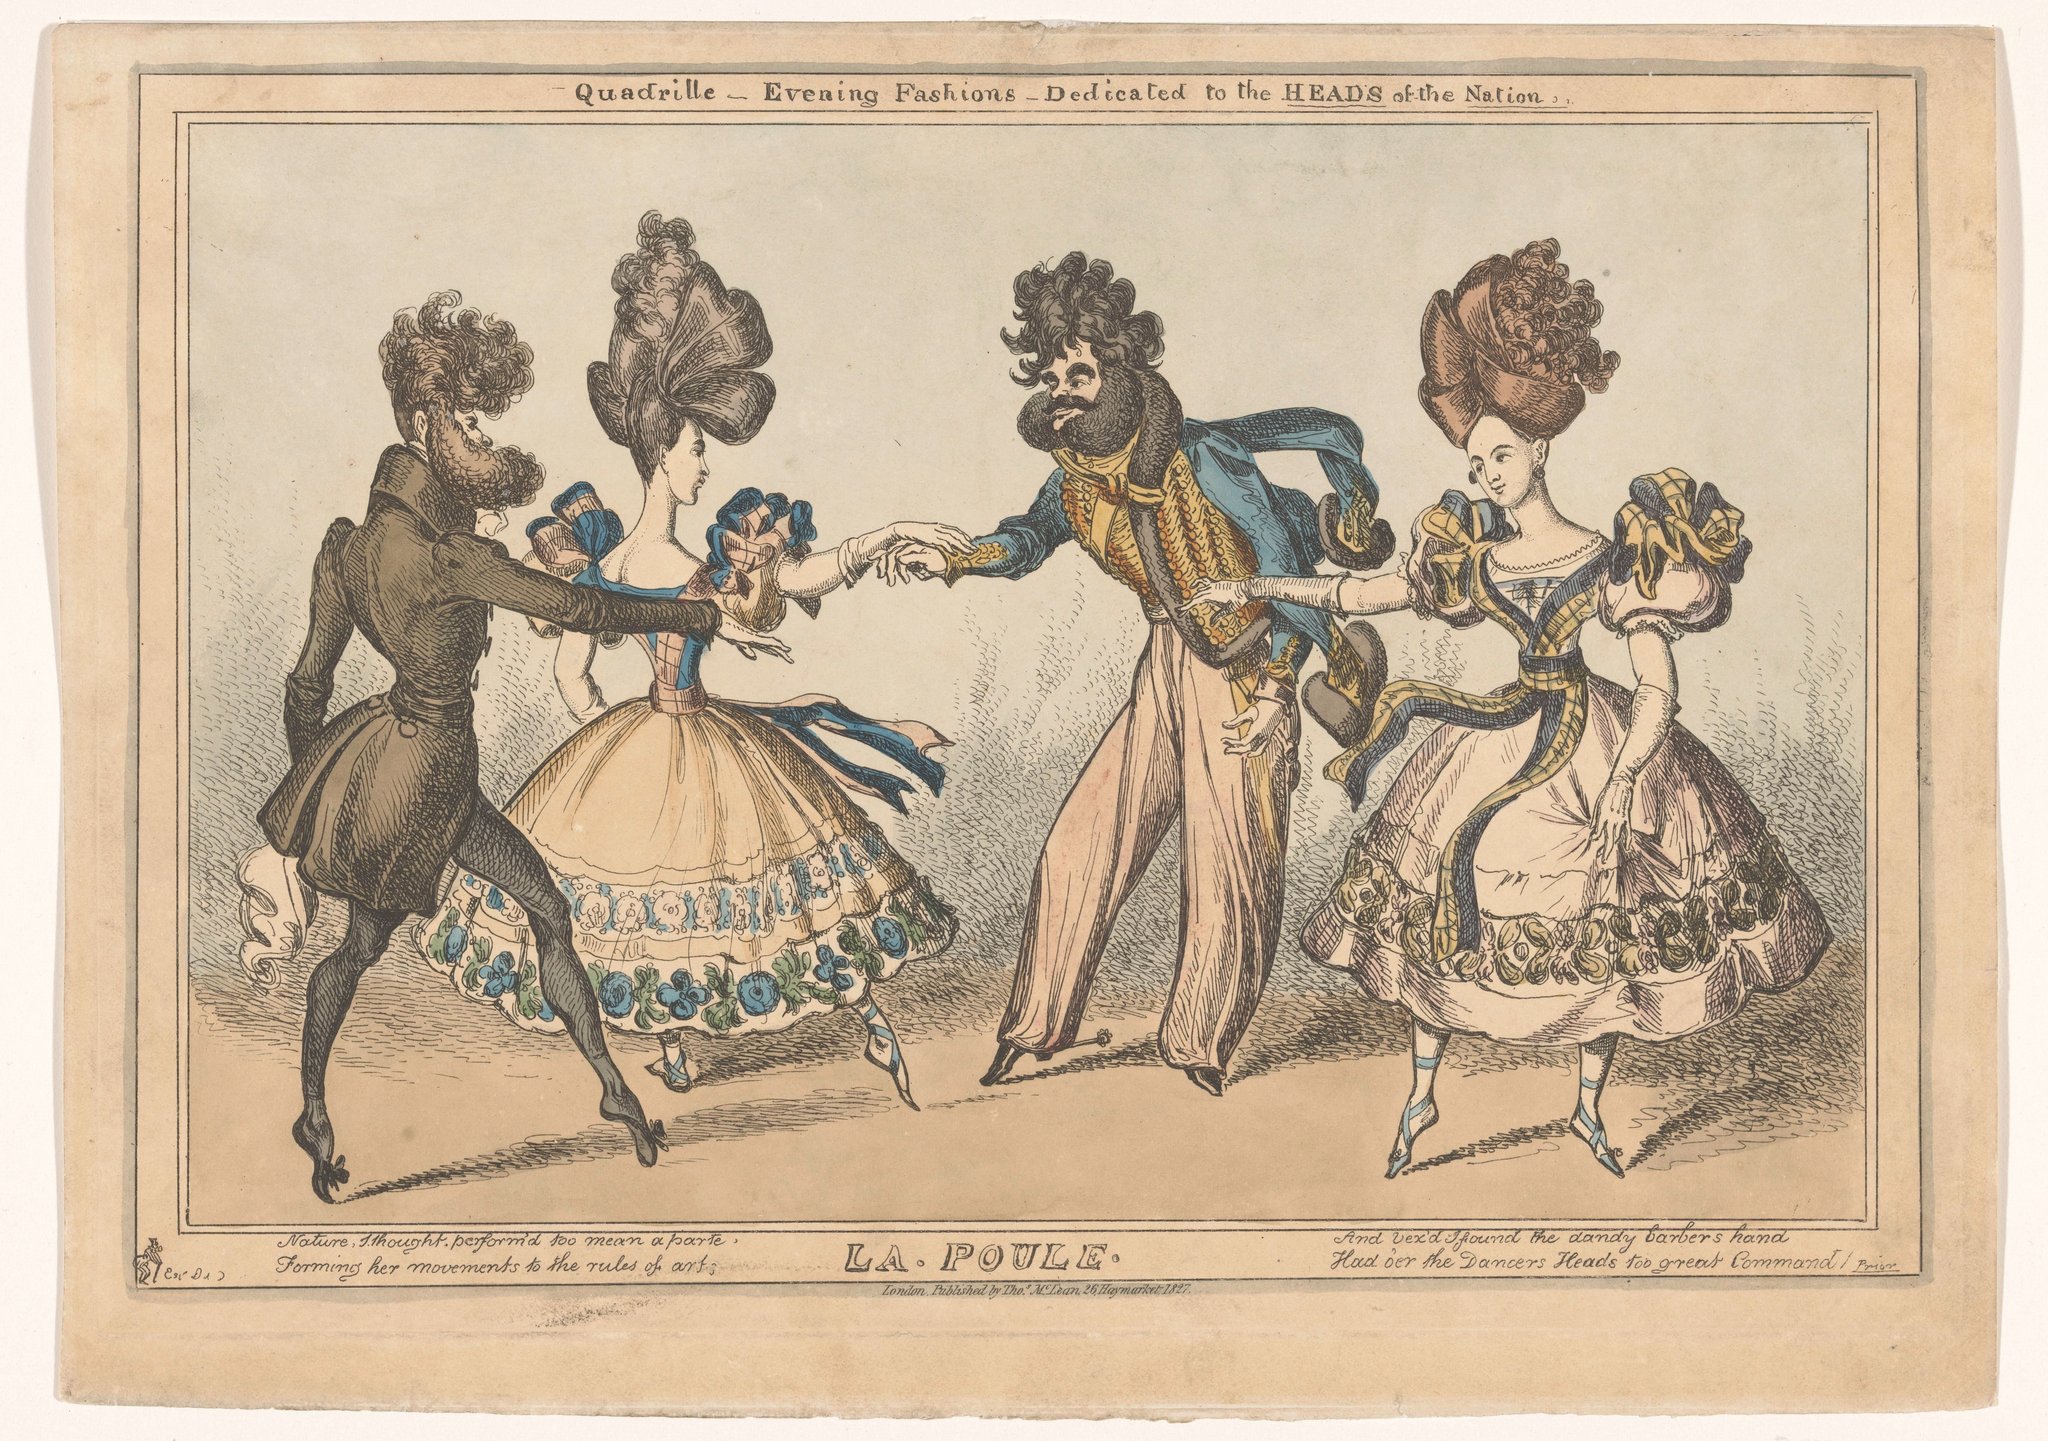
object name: print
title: Quadrille - Evening Fashions - Dedicated to the Heads of the Nation. La Poule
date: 1827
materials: paper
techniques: etching, hand coloring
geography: london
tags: styles of hairdress, more than one couple dancing, hairdress, political caricatures and satires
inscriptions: collector's mark: Lugt 2228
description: Spotprent met twee dansende paren, alle vier met overdreven haardracht.